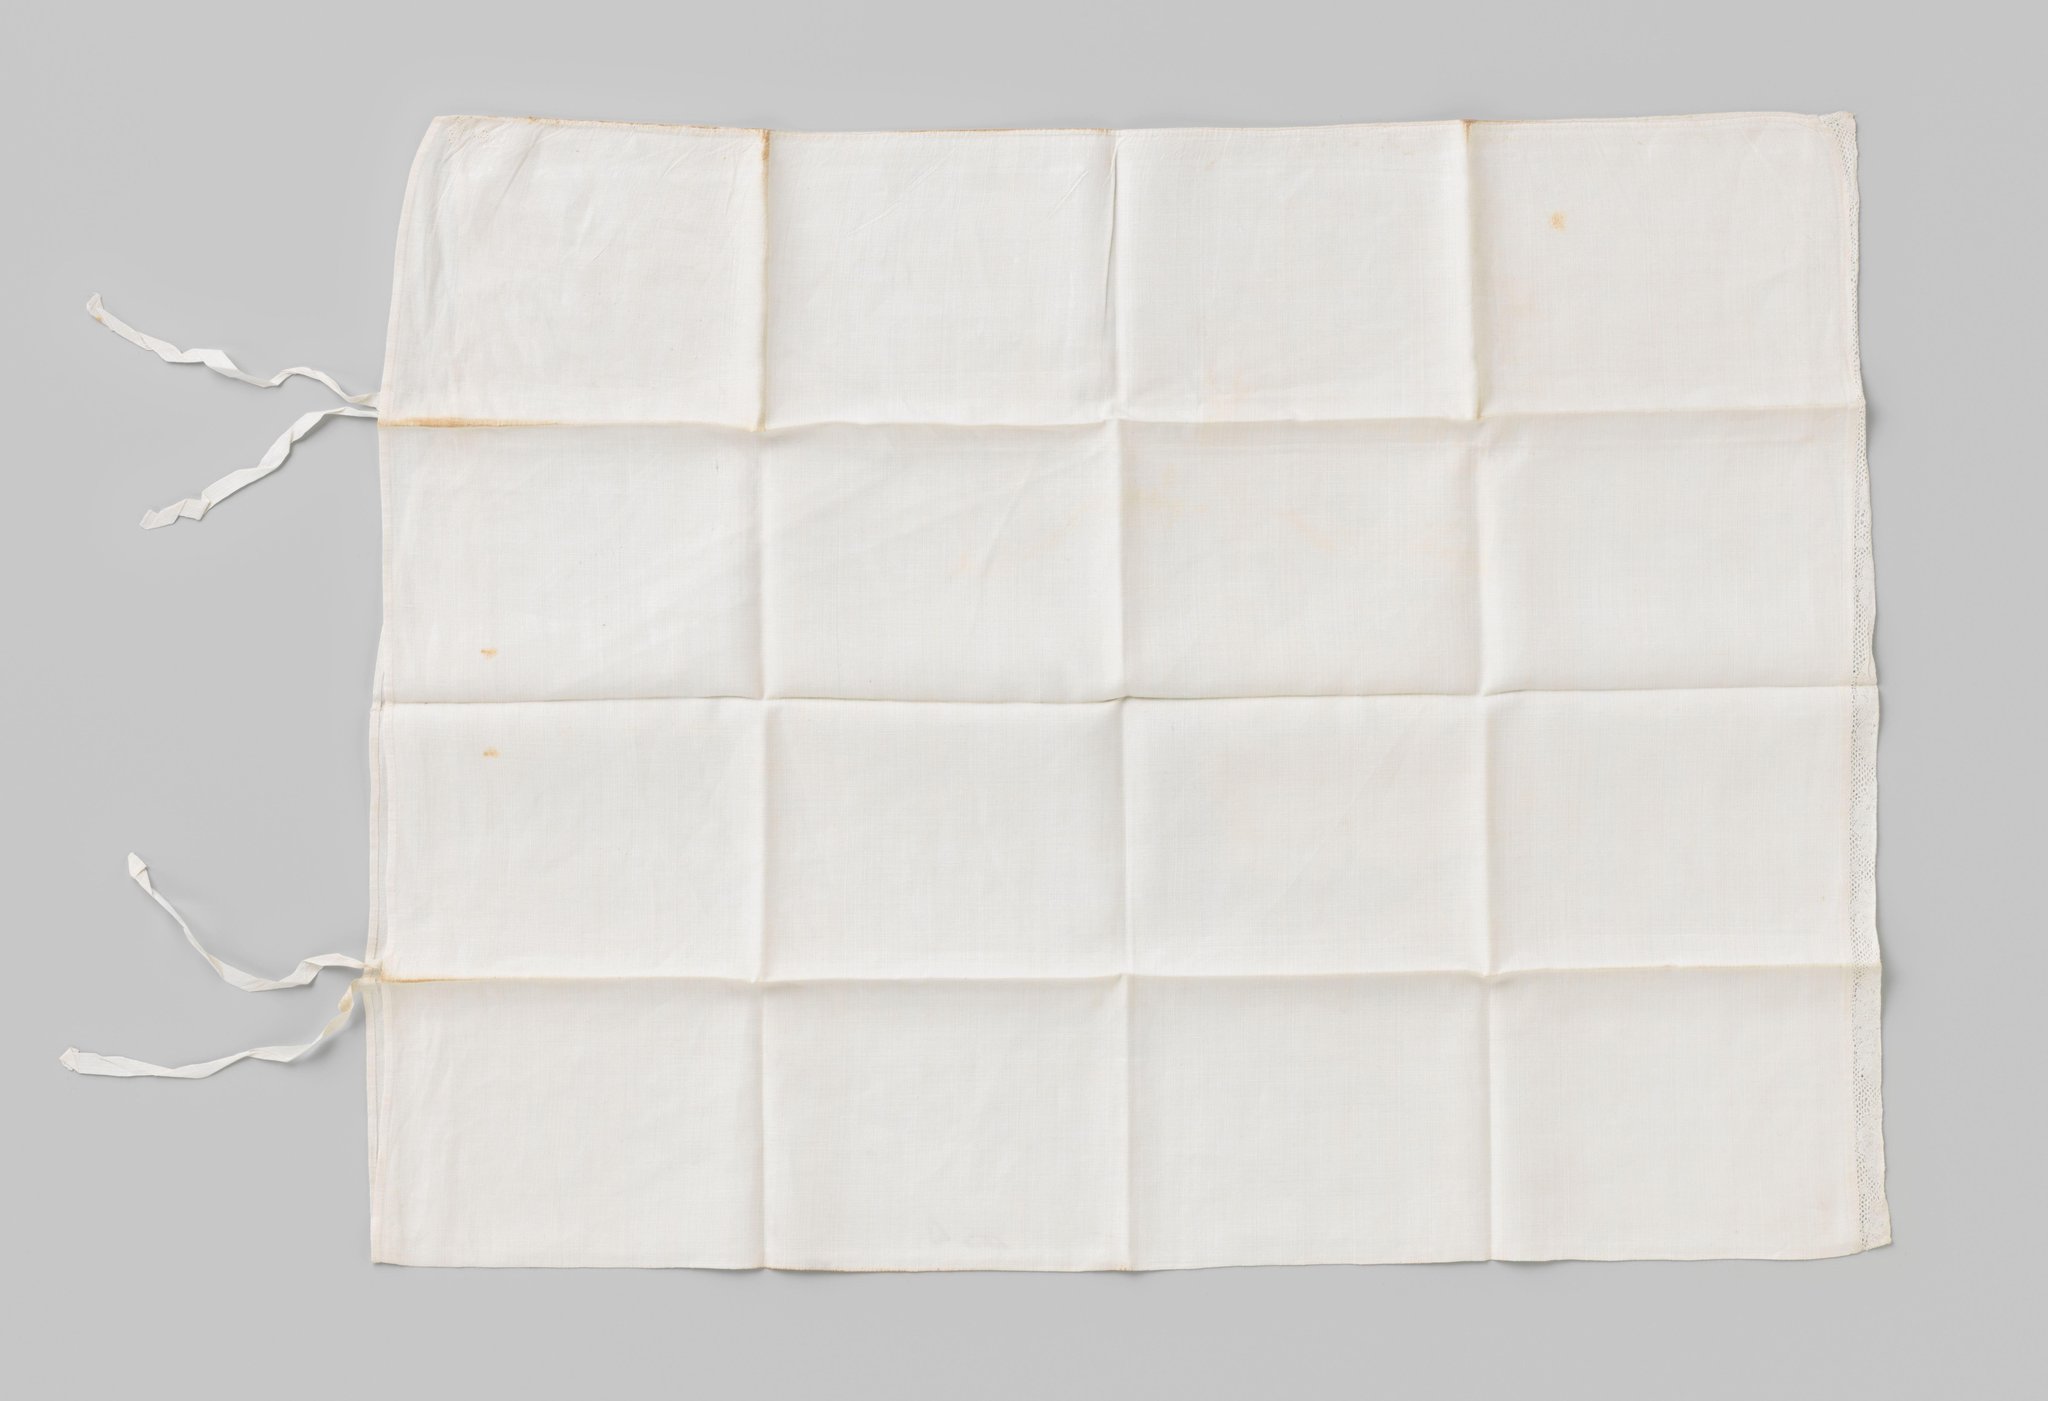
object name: pillowcase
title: Wit kussensloop van linnen met strook kant, gemerkt kroon b 12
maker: Anonymous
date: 1600-1950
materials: linen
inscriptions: mark: ‘kroon Y/J(?) 12’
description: Wit kussensloop van linnen met strook kant, gemerkt in een hoek kroon "b 12". Koordsluiting.